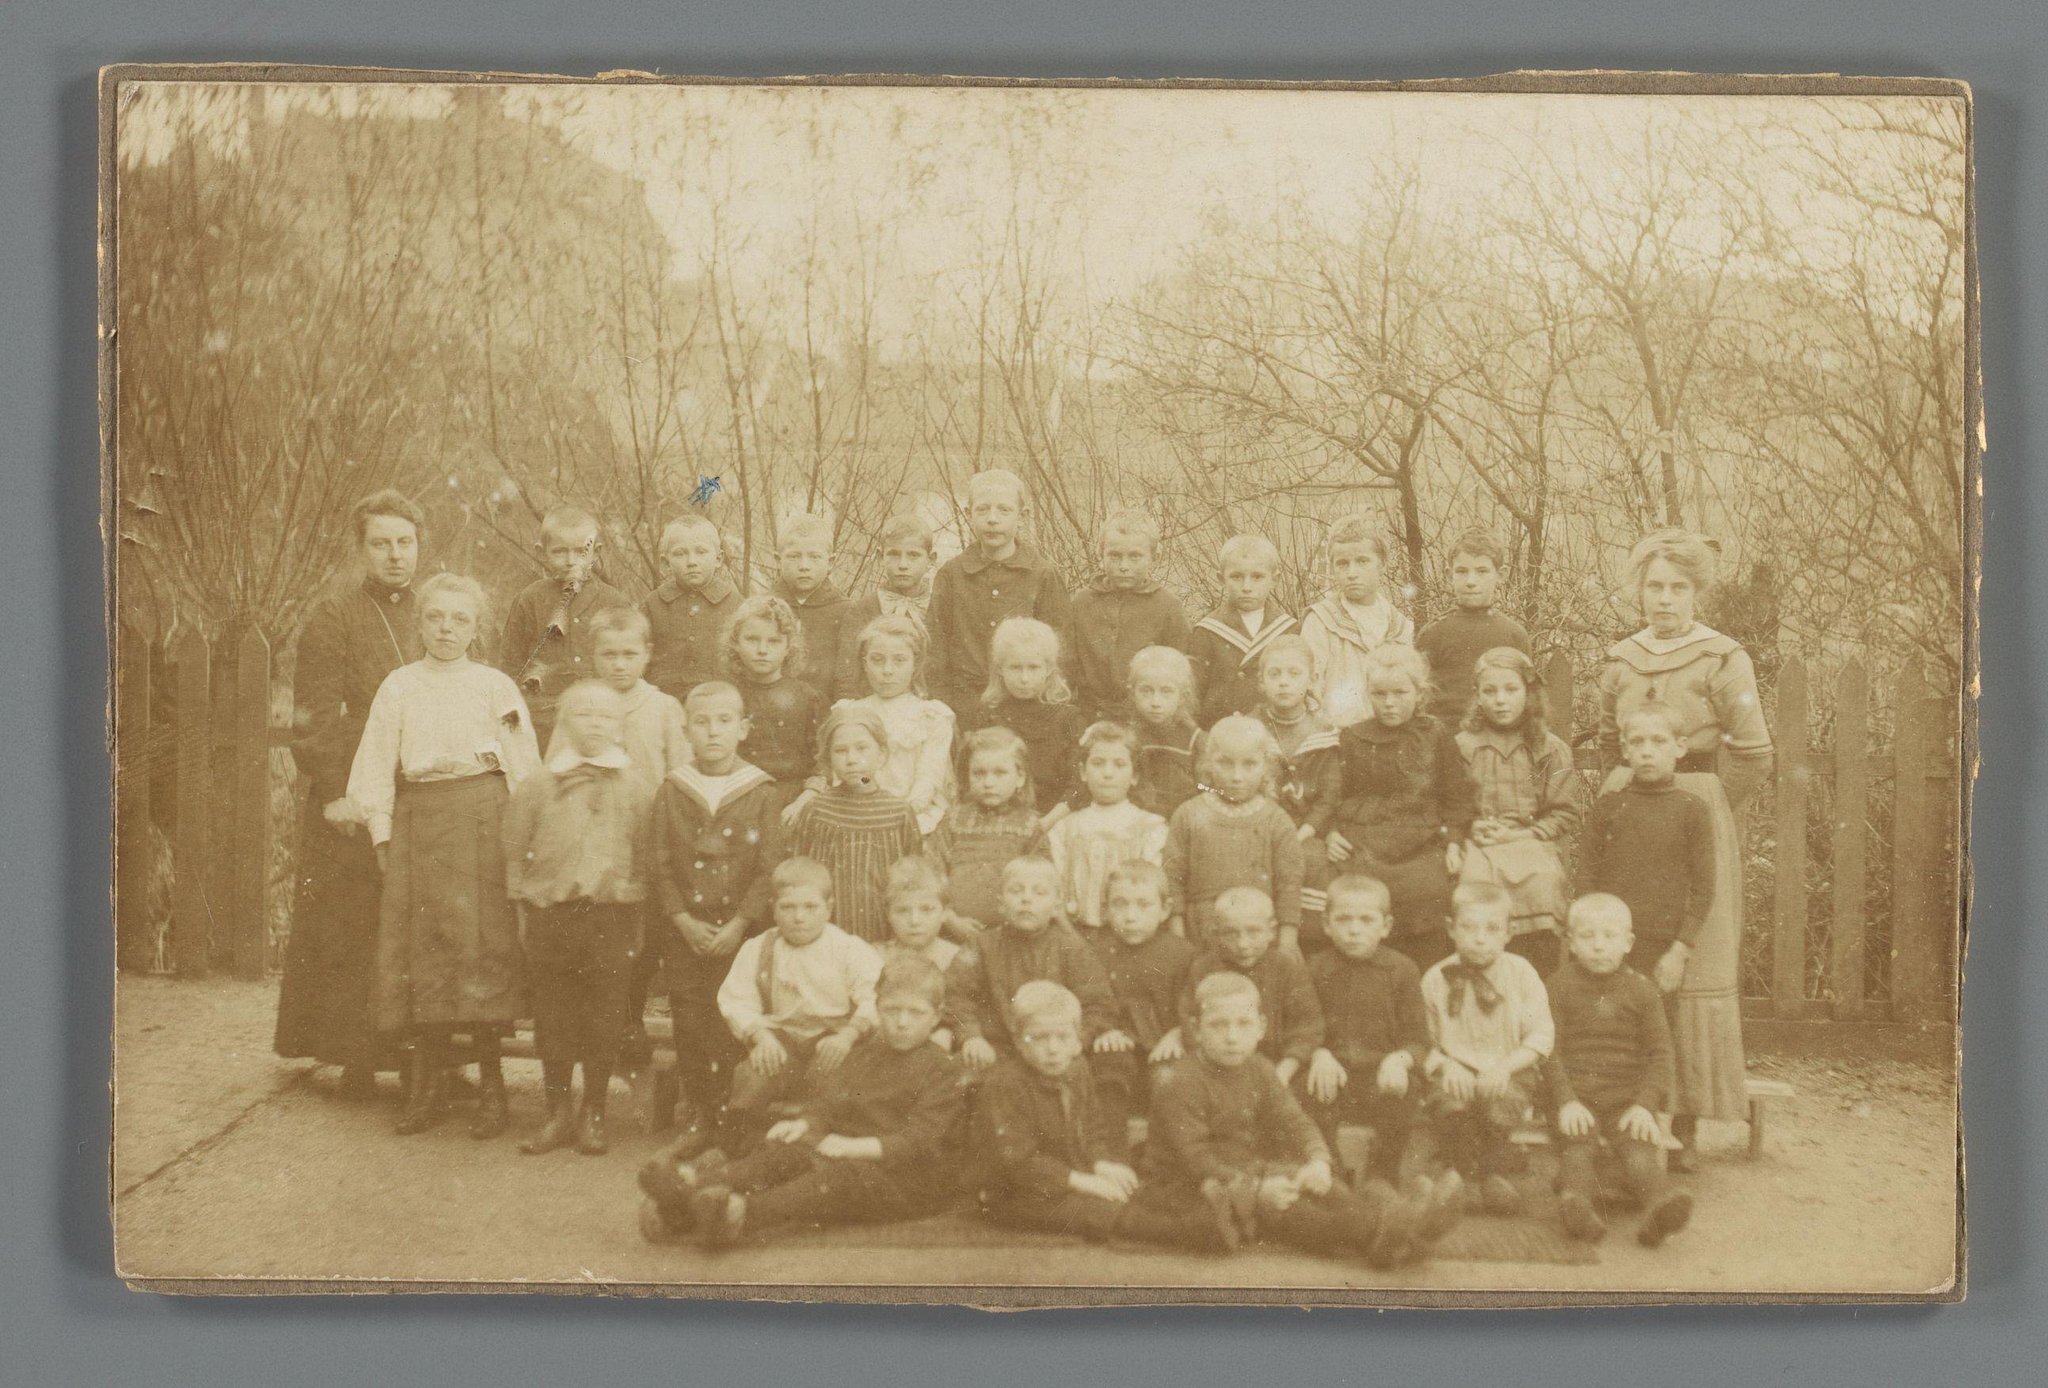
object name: photograph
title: Groepsportret van een onbekende schoolklas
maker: Anonymous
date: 1900-1910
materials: paper, cardboard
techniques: collodion silver print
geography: leeuwarden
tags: elementary school; class, form, anonymous historical persons portrayed in a group, in a group-portrait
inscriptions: inscription: ‘onze Gerrit/ Mendel’